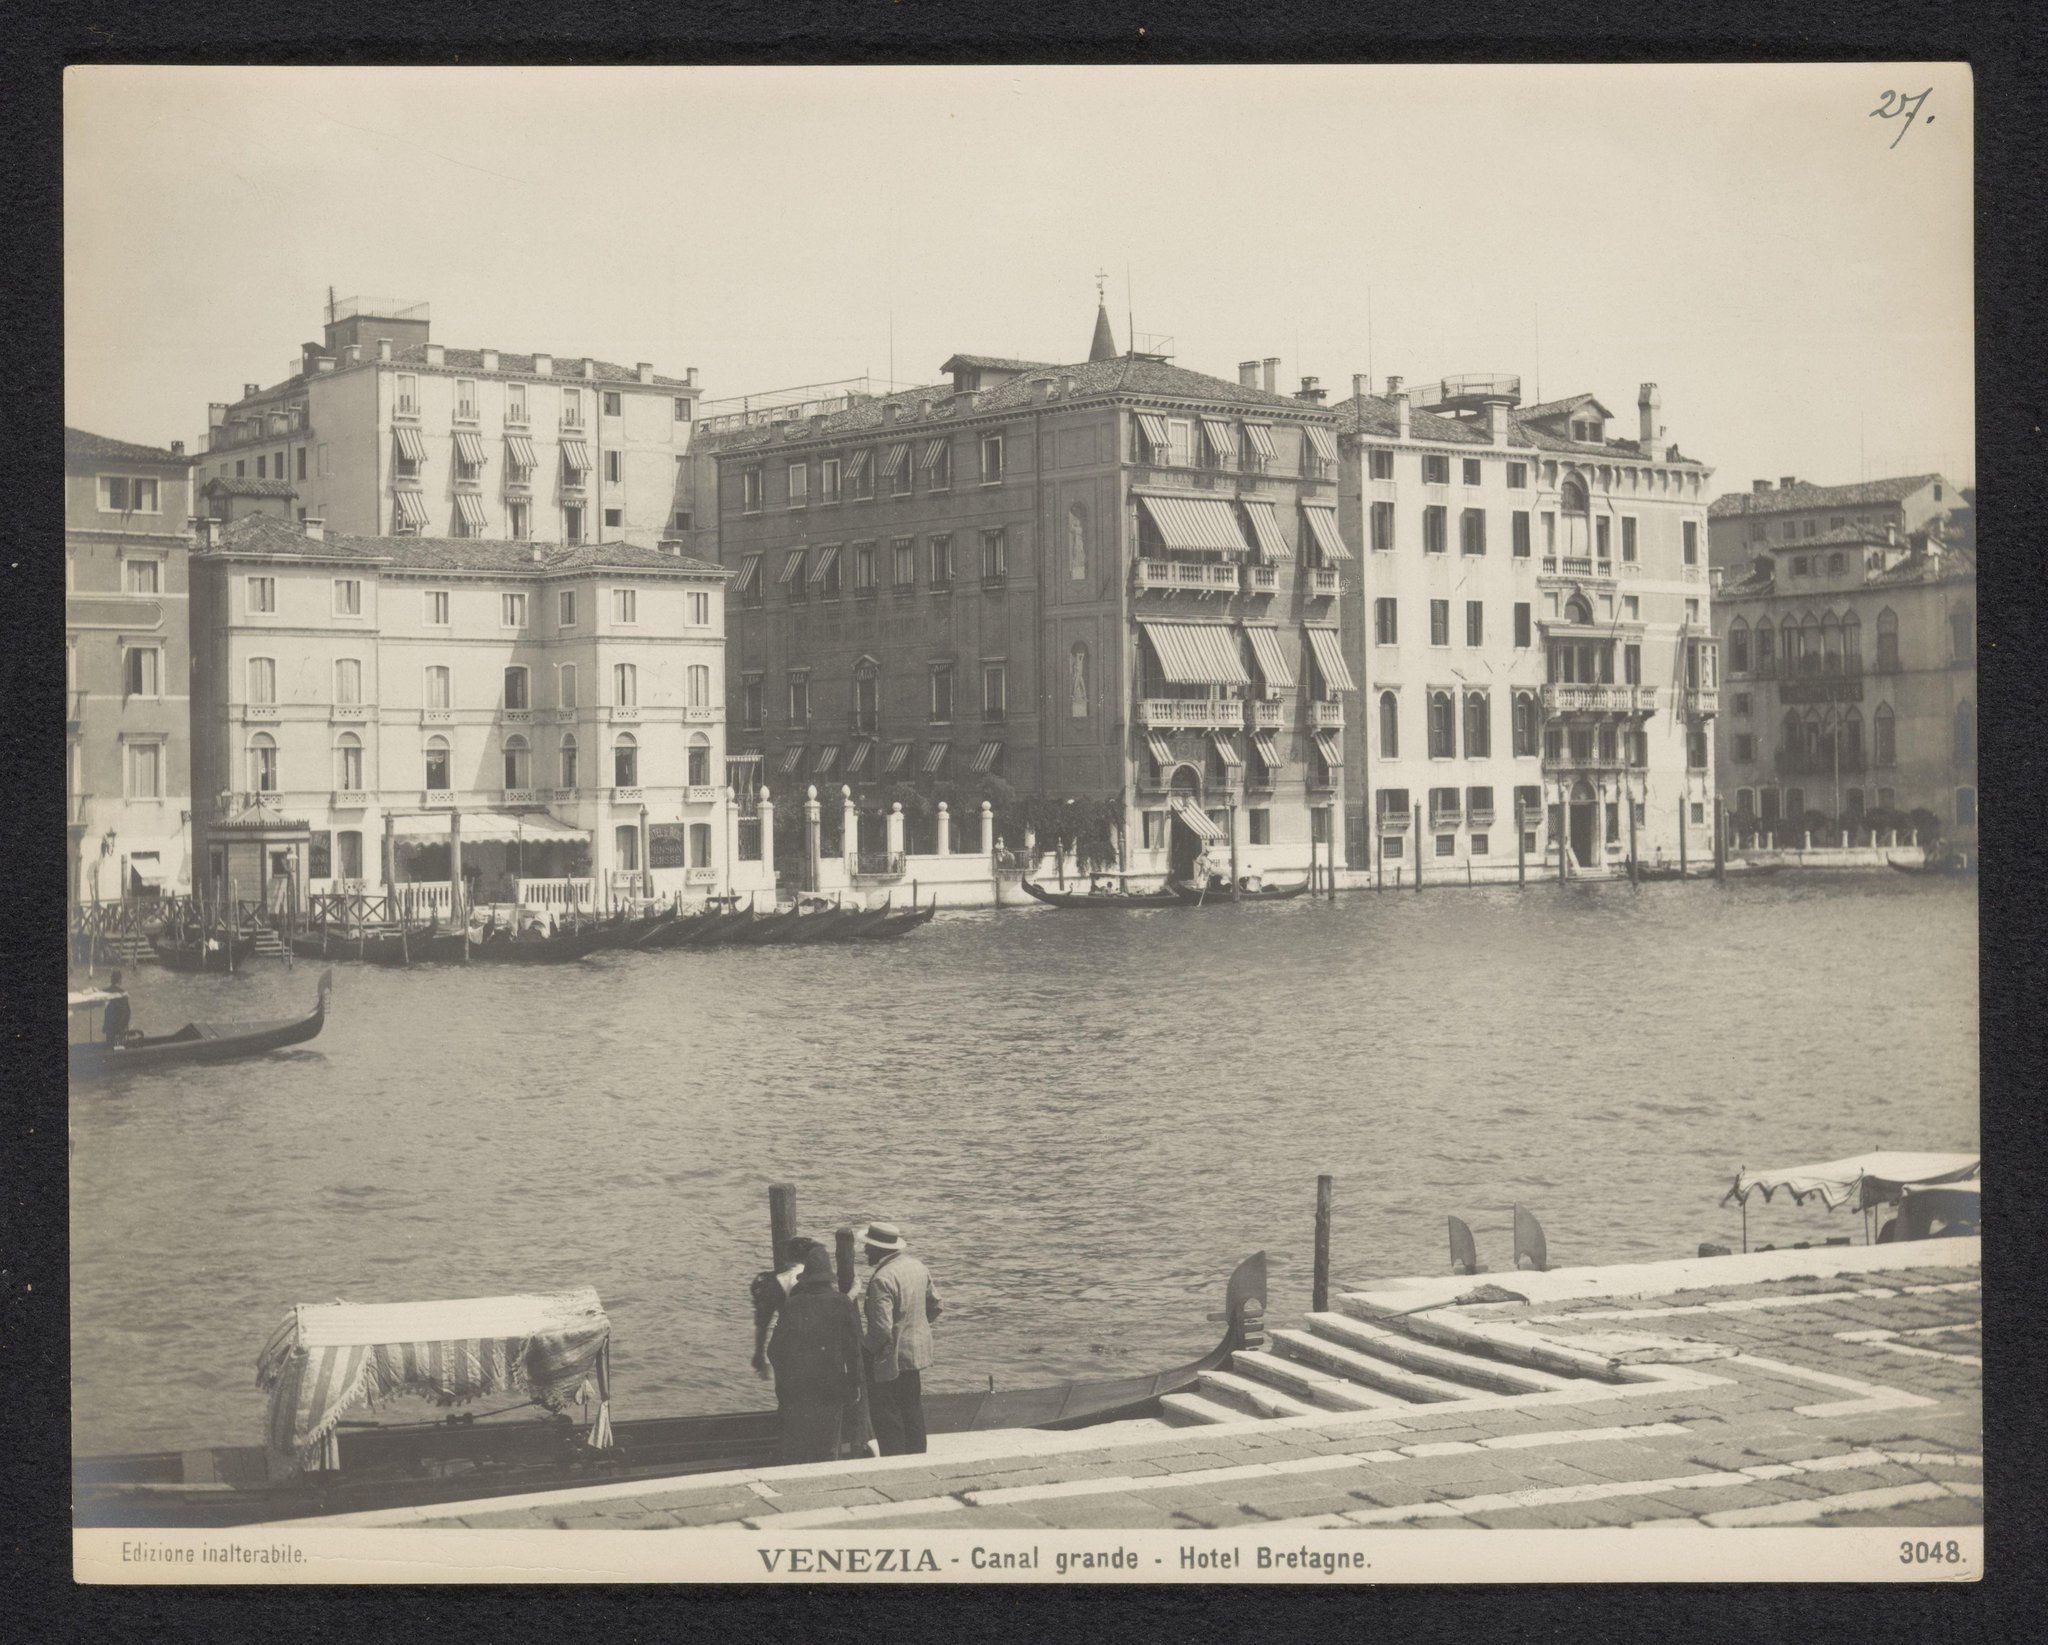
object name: photograph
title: Exterieur van Hotel Bretagne te Venetië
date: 1900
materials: cardboard, photographic support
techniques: gelatin silver print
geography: venice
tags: canal, façade (of house or building), hotel, hostelry, inn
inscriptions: number: ‘3048.’, number: ‘27.’